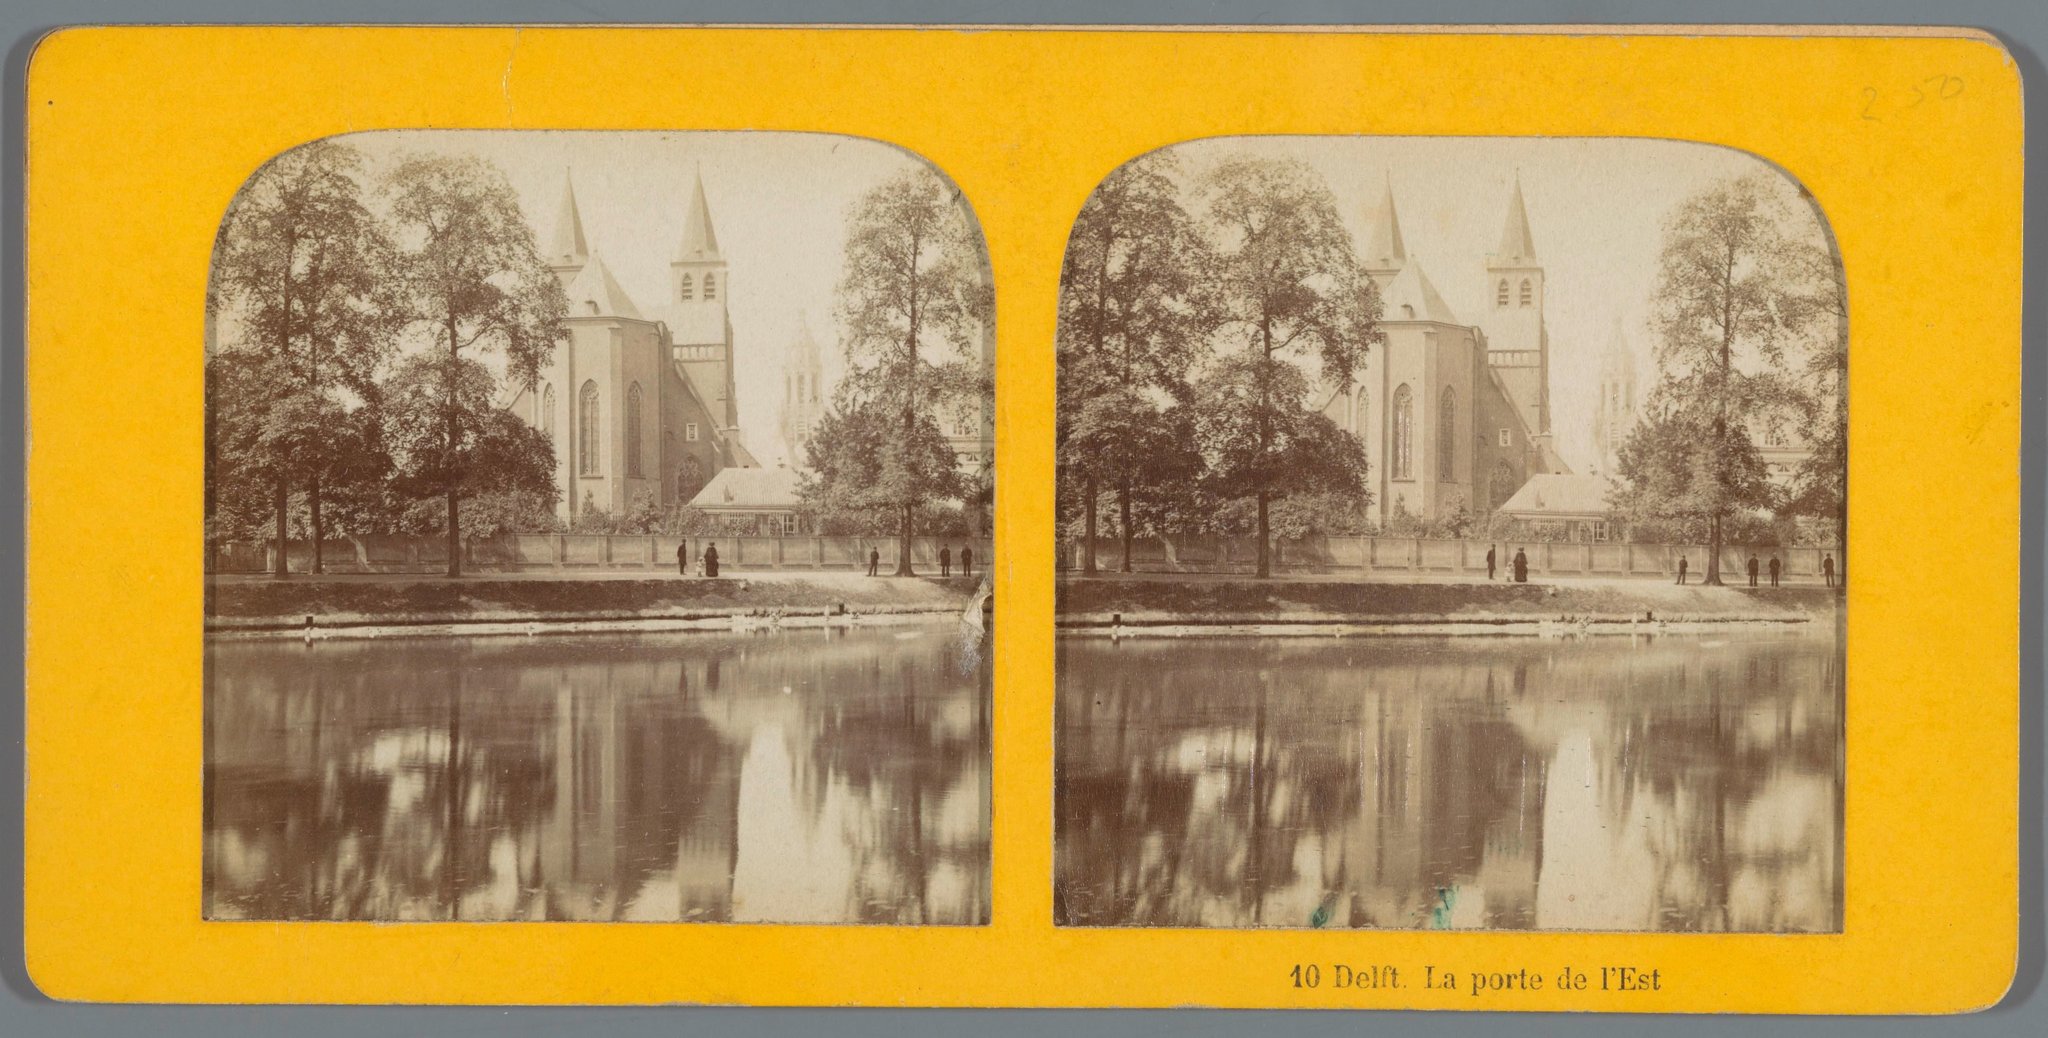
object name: tissue stereograph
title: Gezicht op de Walburgiskerk te Arnhem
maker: Anonymous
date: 1855-1875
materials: cardboard, paper, photographic support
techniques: albumen print, hand coloring, perforating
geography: delft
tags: church (exterior), canals, waters (in city), arnhem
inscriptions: number: ‘10’, number: ‘9’